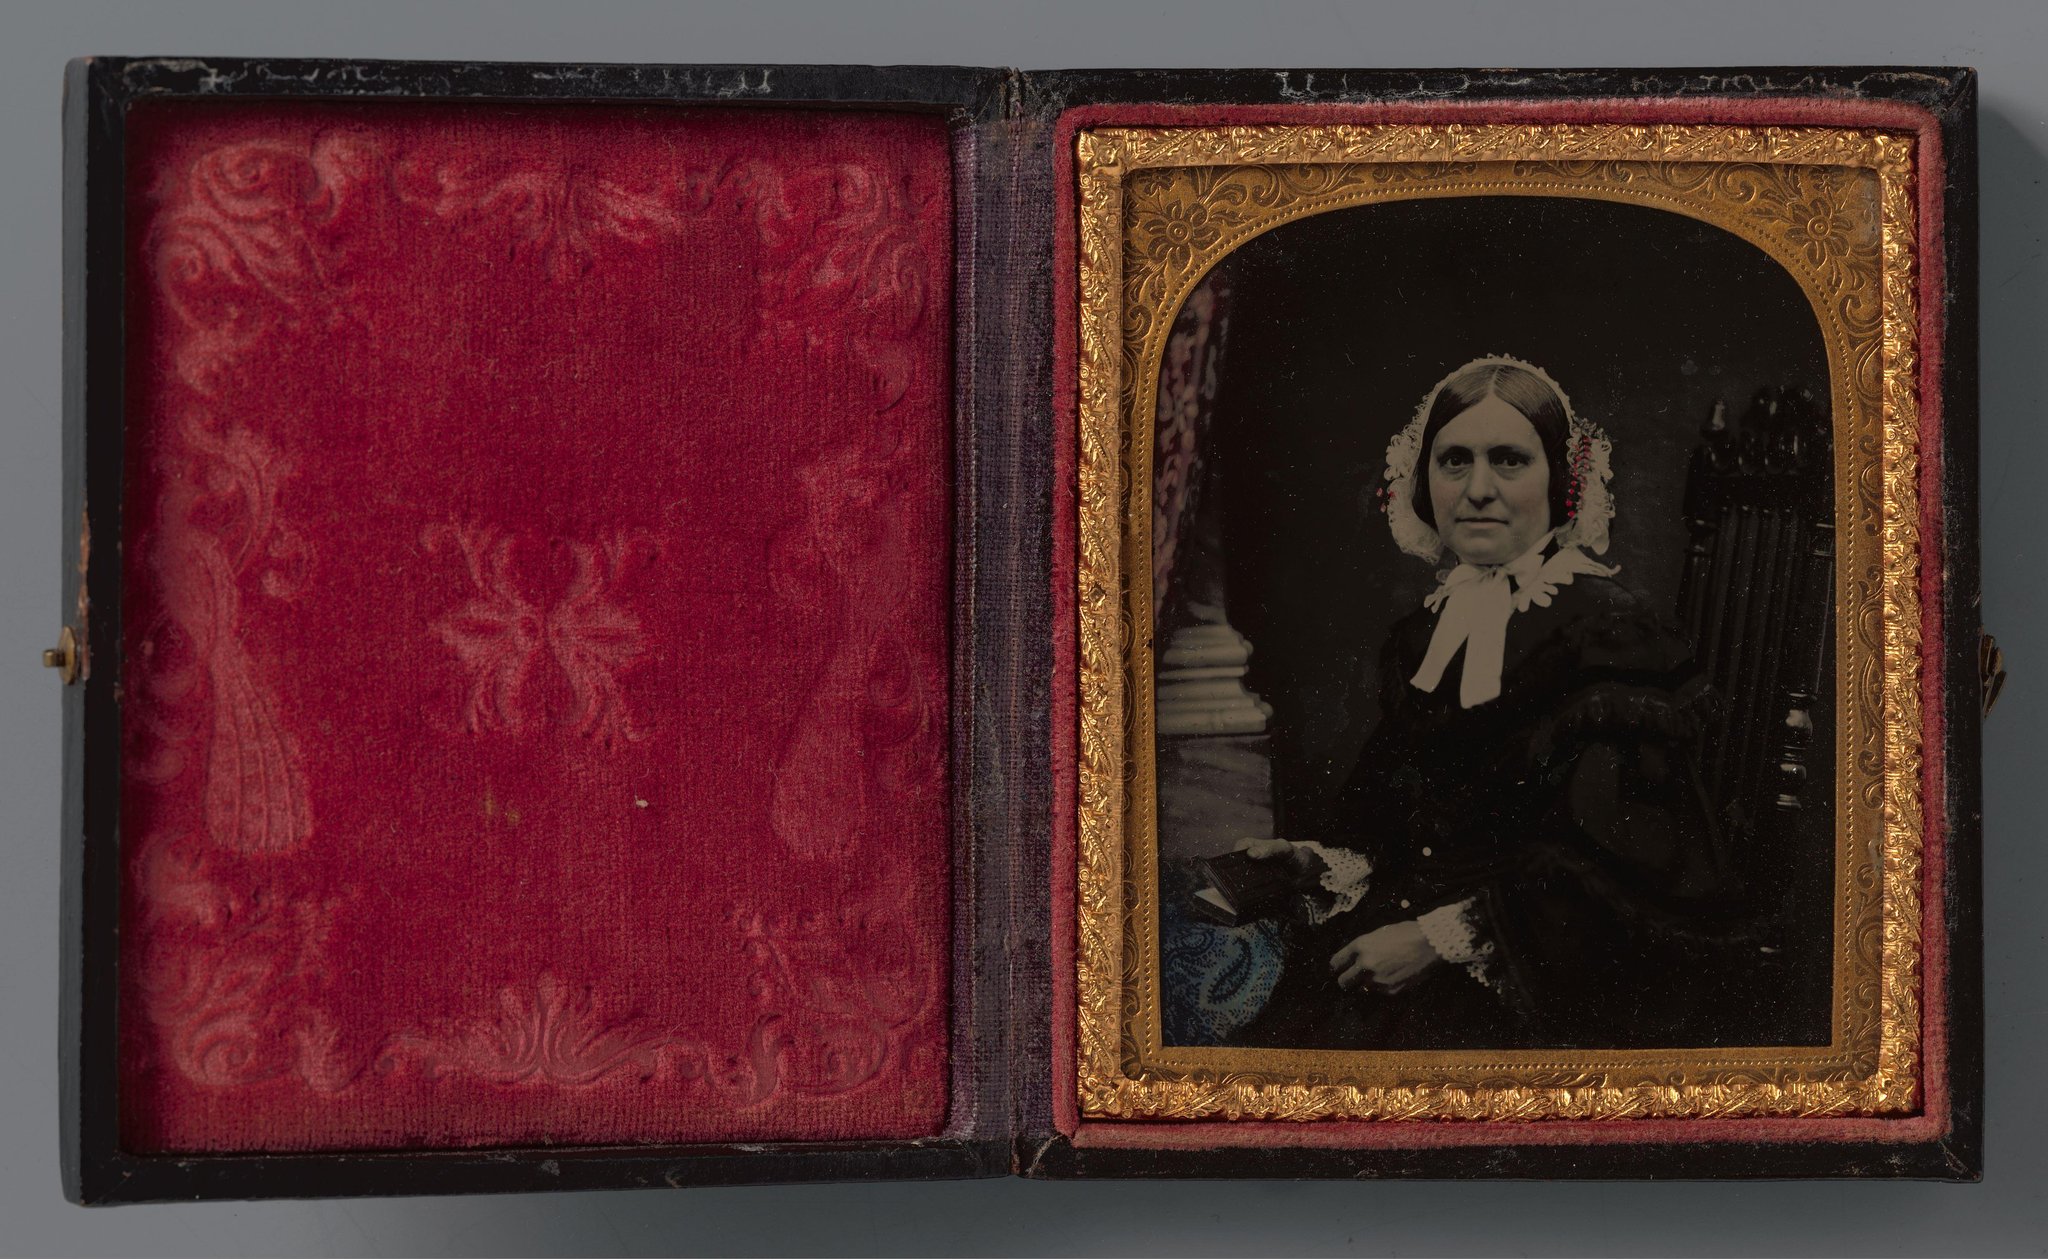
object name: photograph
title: Portret van een onbekende vrouw met muts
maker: Anonymous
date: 1855-1870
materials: glass, metal, velvet, wood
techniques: ambrotype, hand coloring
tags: sitting figure - aa - female human figure, historical persons - bb - woman, head-gear: cap